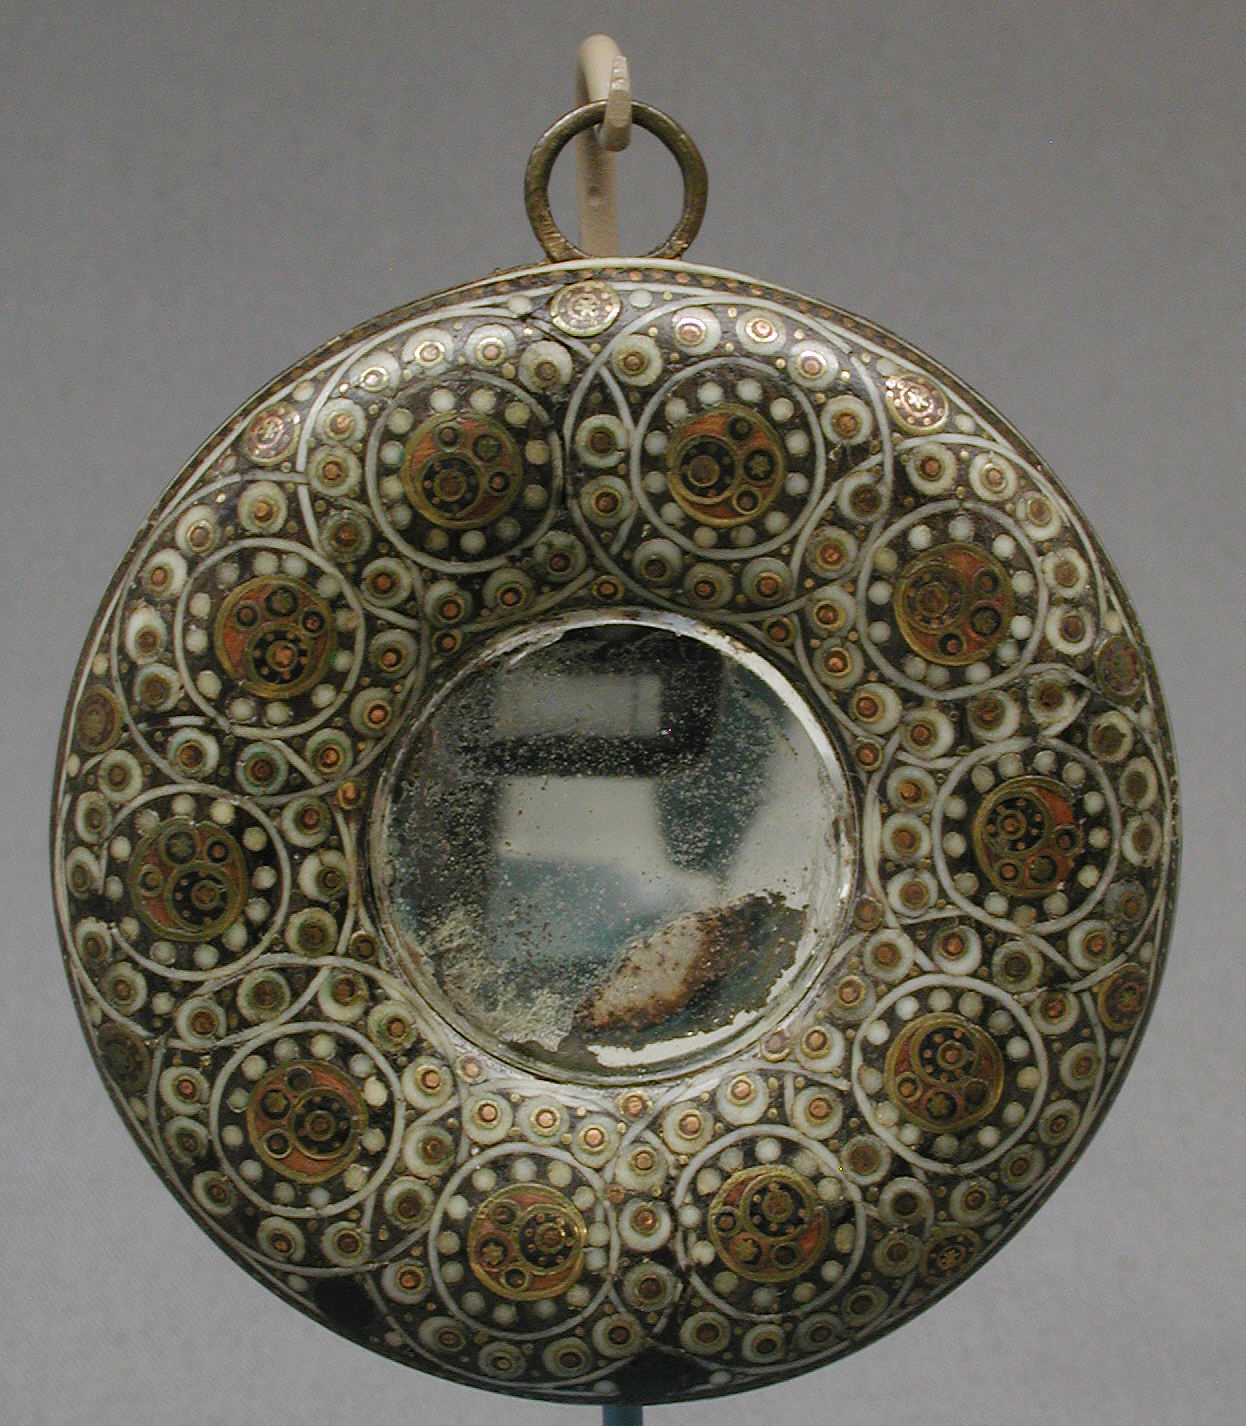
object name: frame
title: Frame for a mirror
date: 1501-1600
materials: ivory, metal, wood